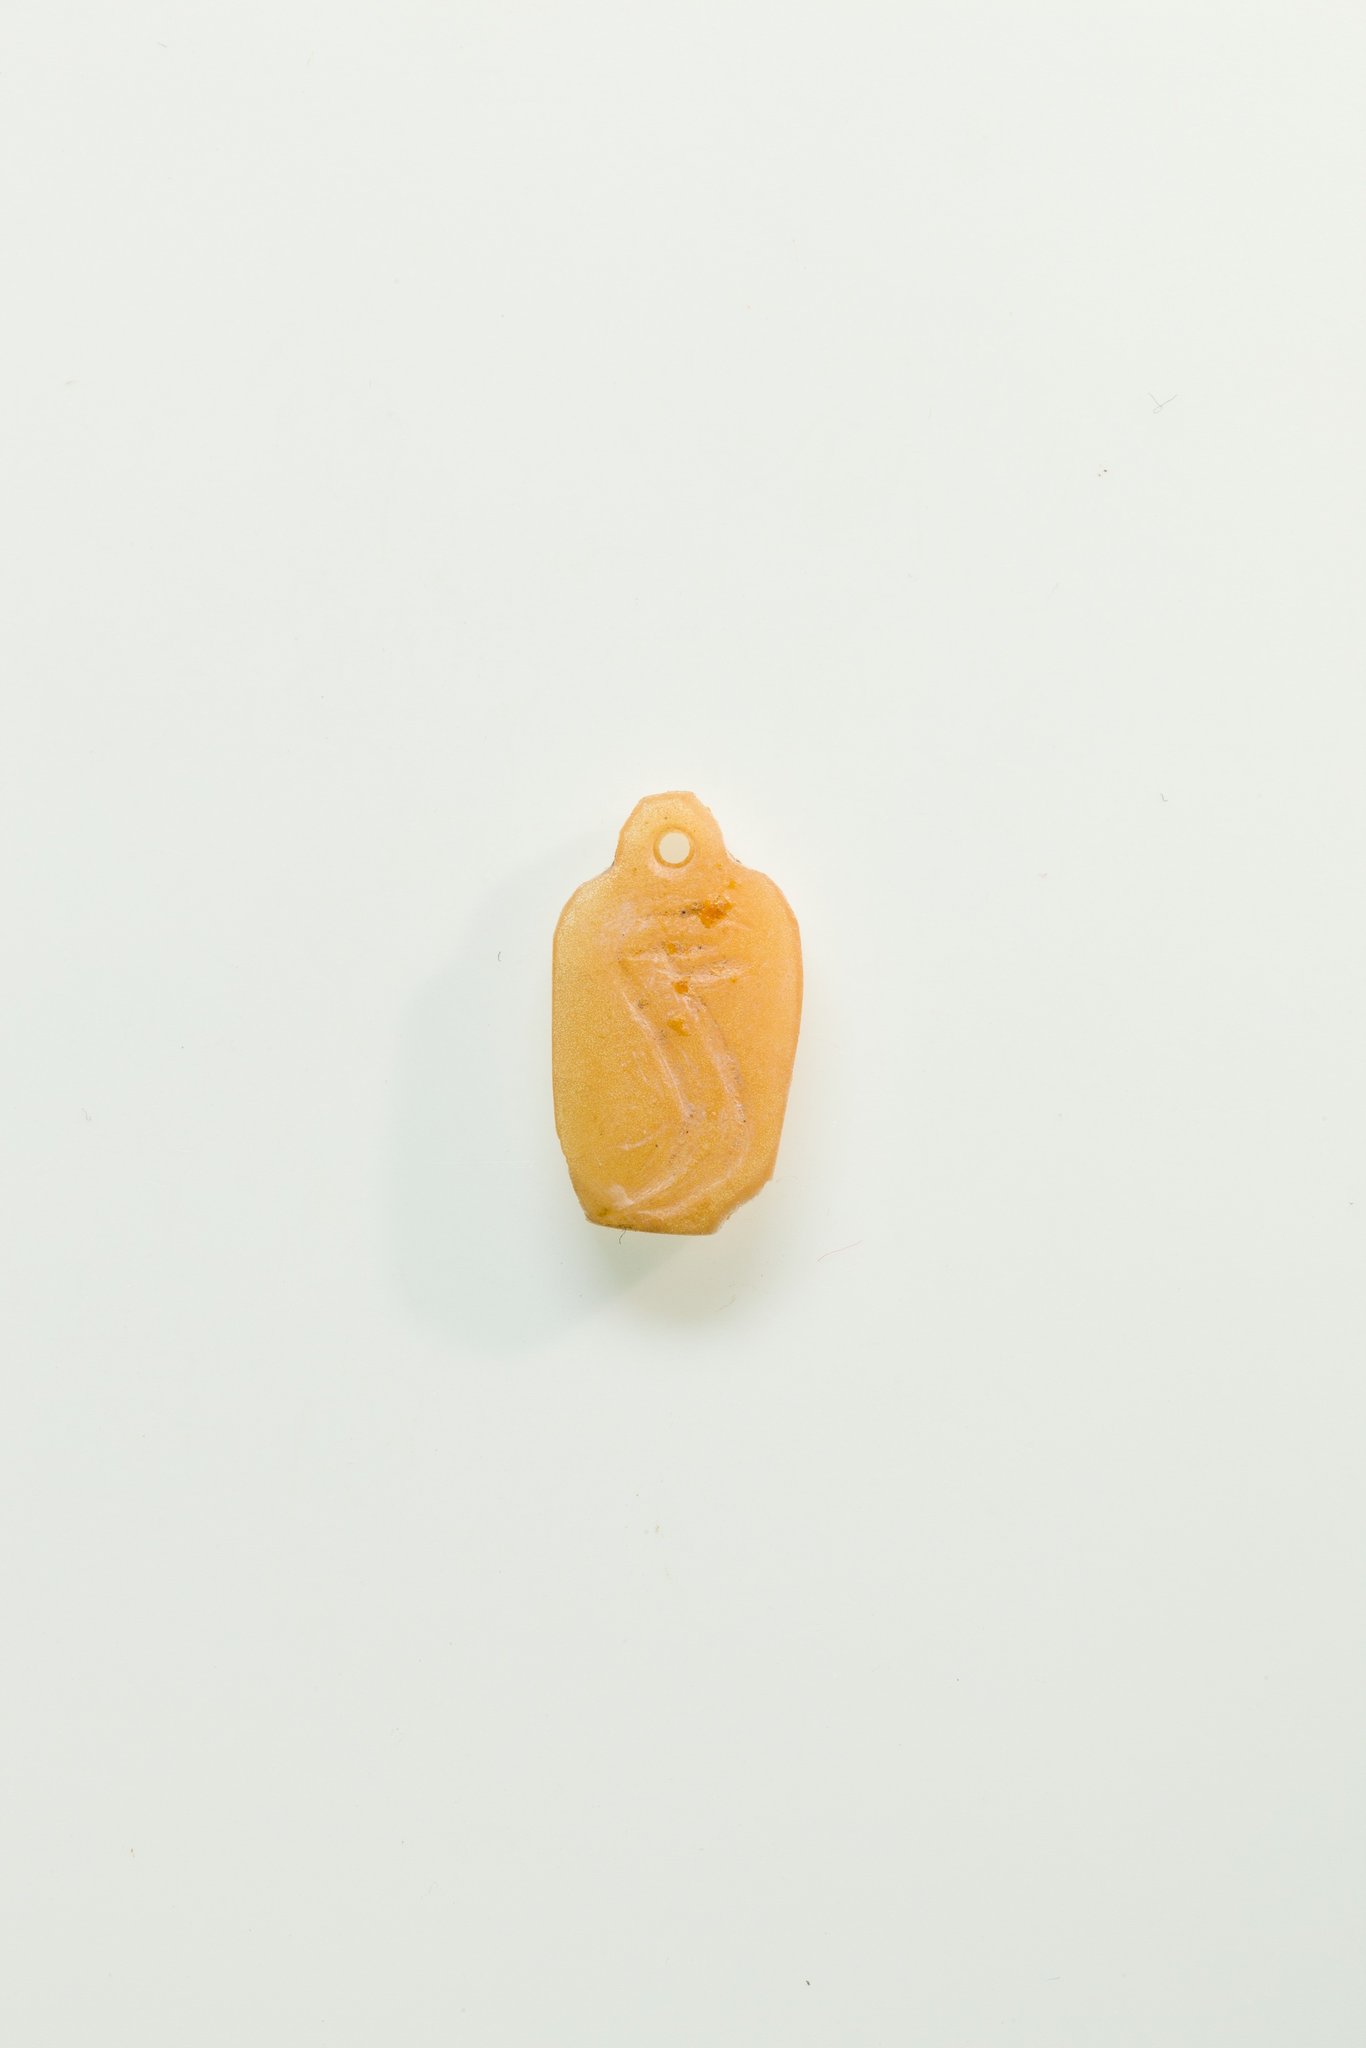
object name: uraeus plaque amulet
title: Uraeus plaque from a string of amulets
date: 1070-945 BCE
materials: gemstone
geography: egypt